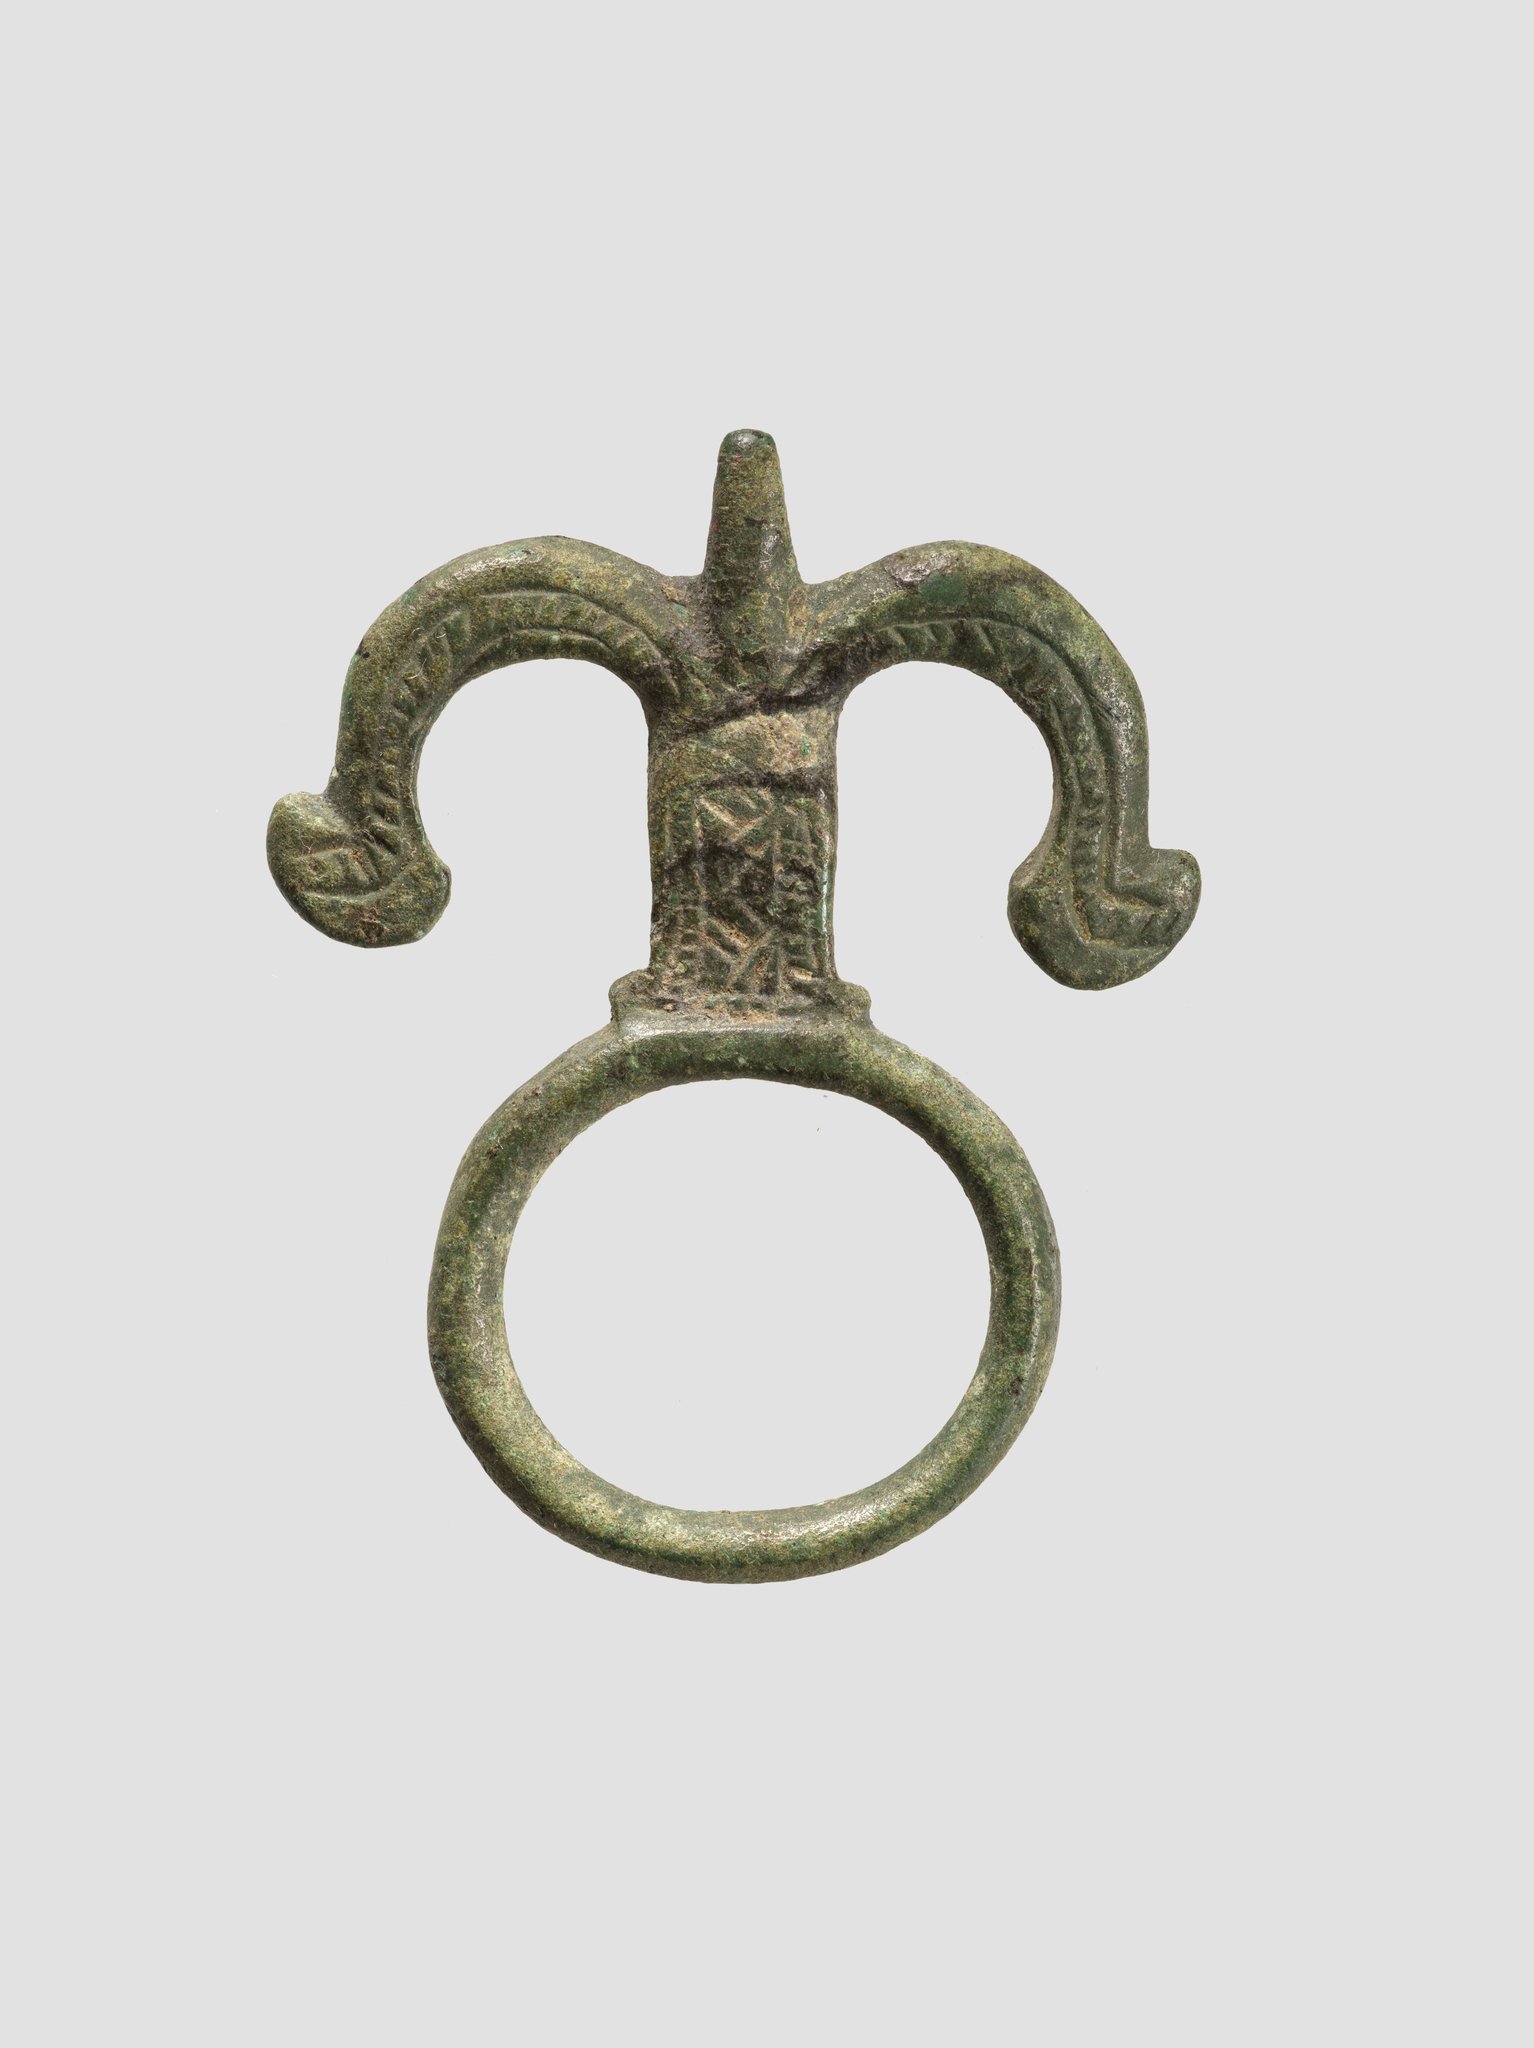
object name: ornament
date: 1-1000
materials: bronze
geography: anatolia (?)